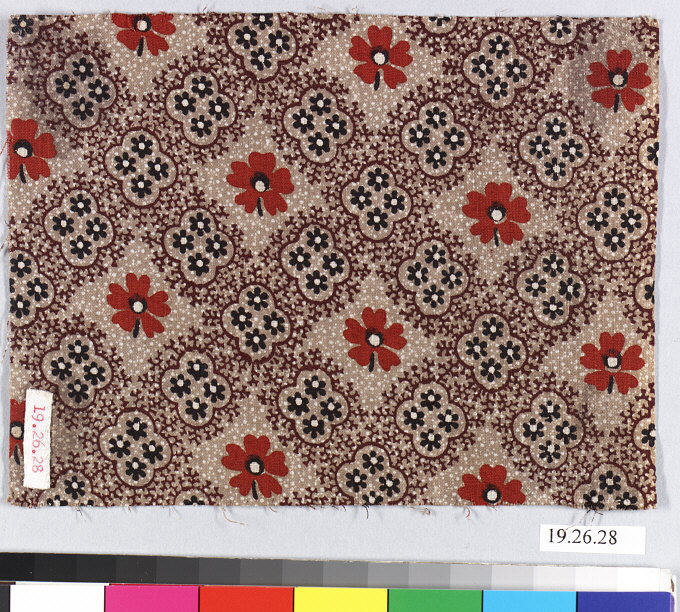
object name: sample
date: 1840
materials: cotton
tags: flowers